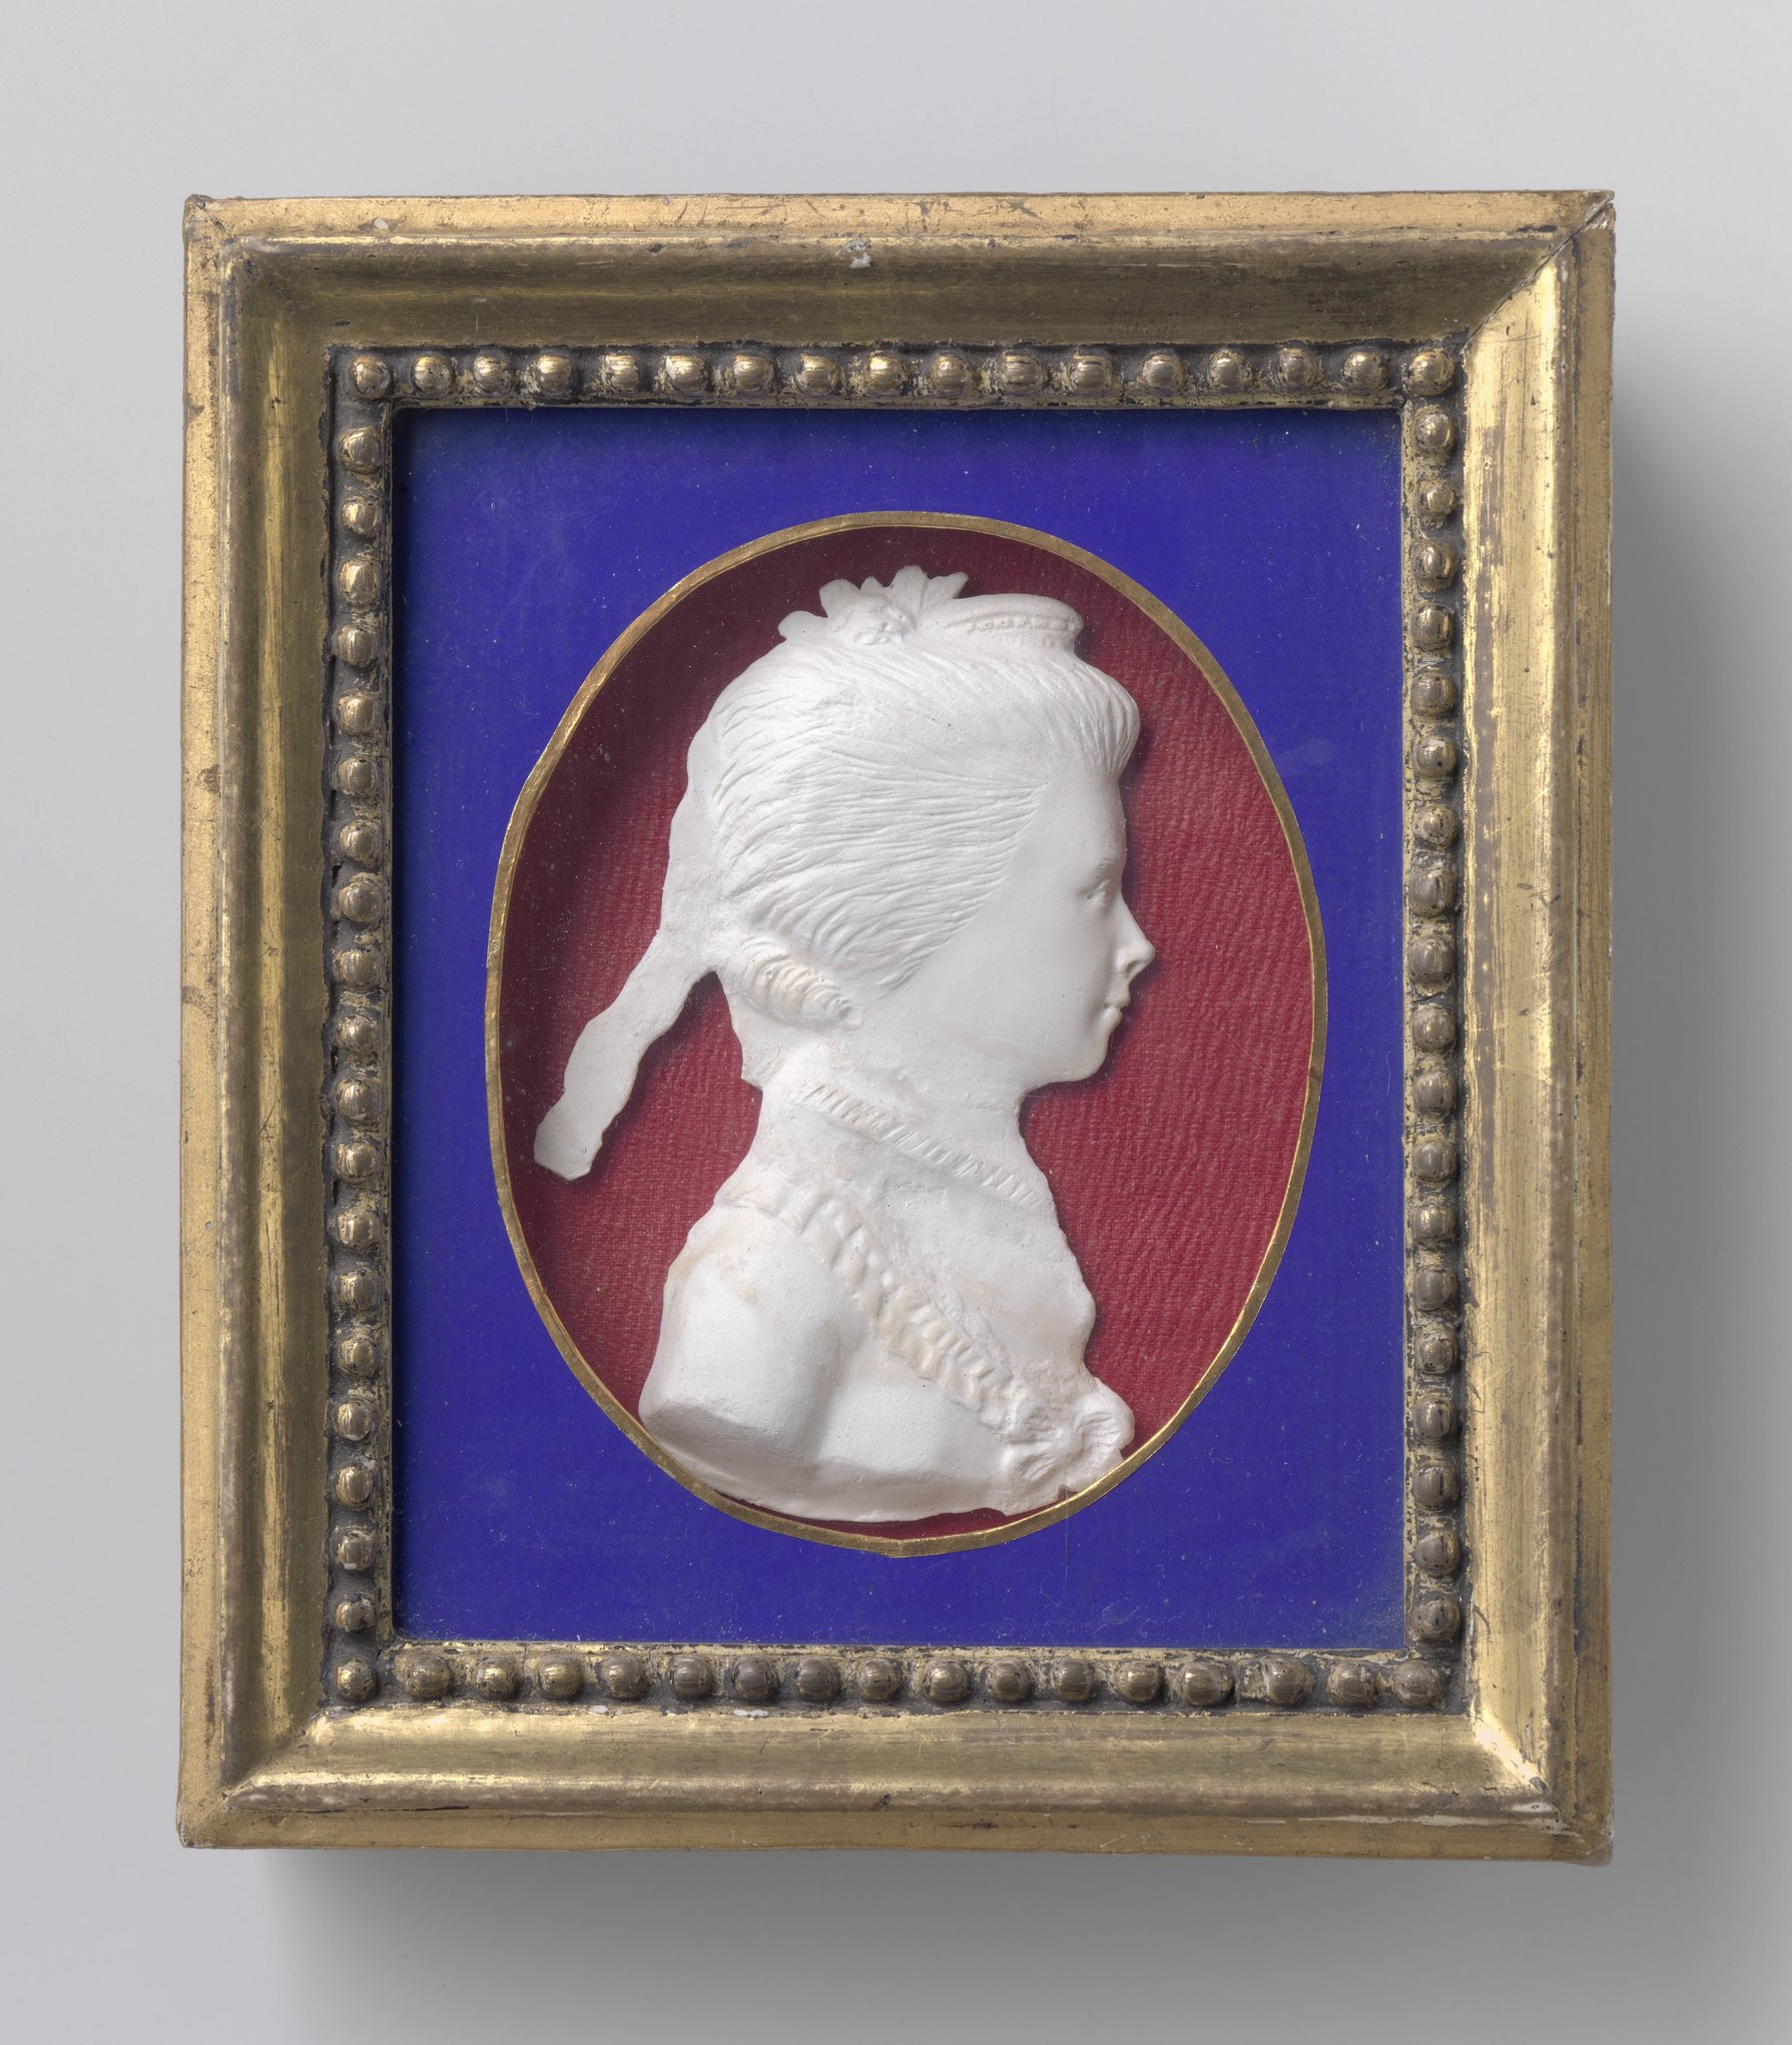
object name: portretmedaillon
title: Portretmedaillon van Prinses Frederika Sophia Wilhelmina van Pruisen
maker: johann heinrich schepp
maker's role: sculptor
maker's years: 1736-1811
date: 1784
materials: gypsum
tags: berlin, painter, draughtsman, wilhelmina of prussia (princess of orange)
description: Portretmedaillon van prinses Frederika Sophia Wilhelmina van Pruisen. De prinses, bijgenaamd Willemijntje, naar rechts, met diadeem in het haar en een kostuum, afgezet met kant. Een lint wappert van het hoofd naar achteren.